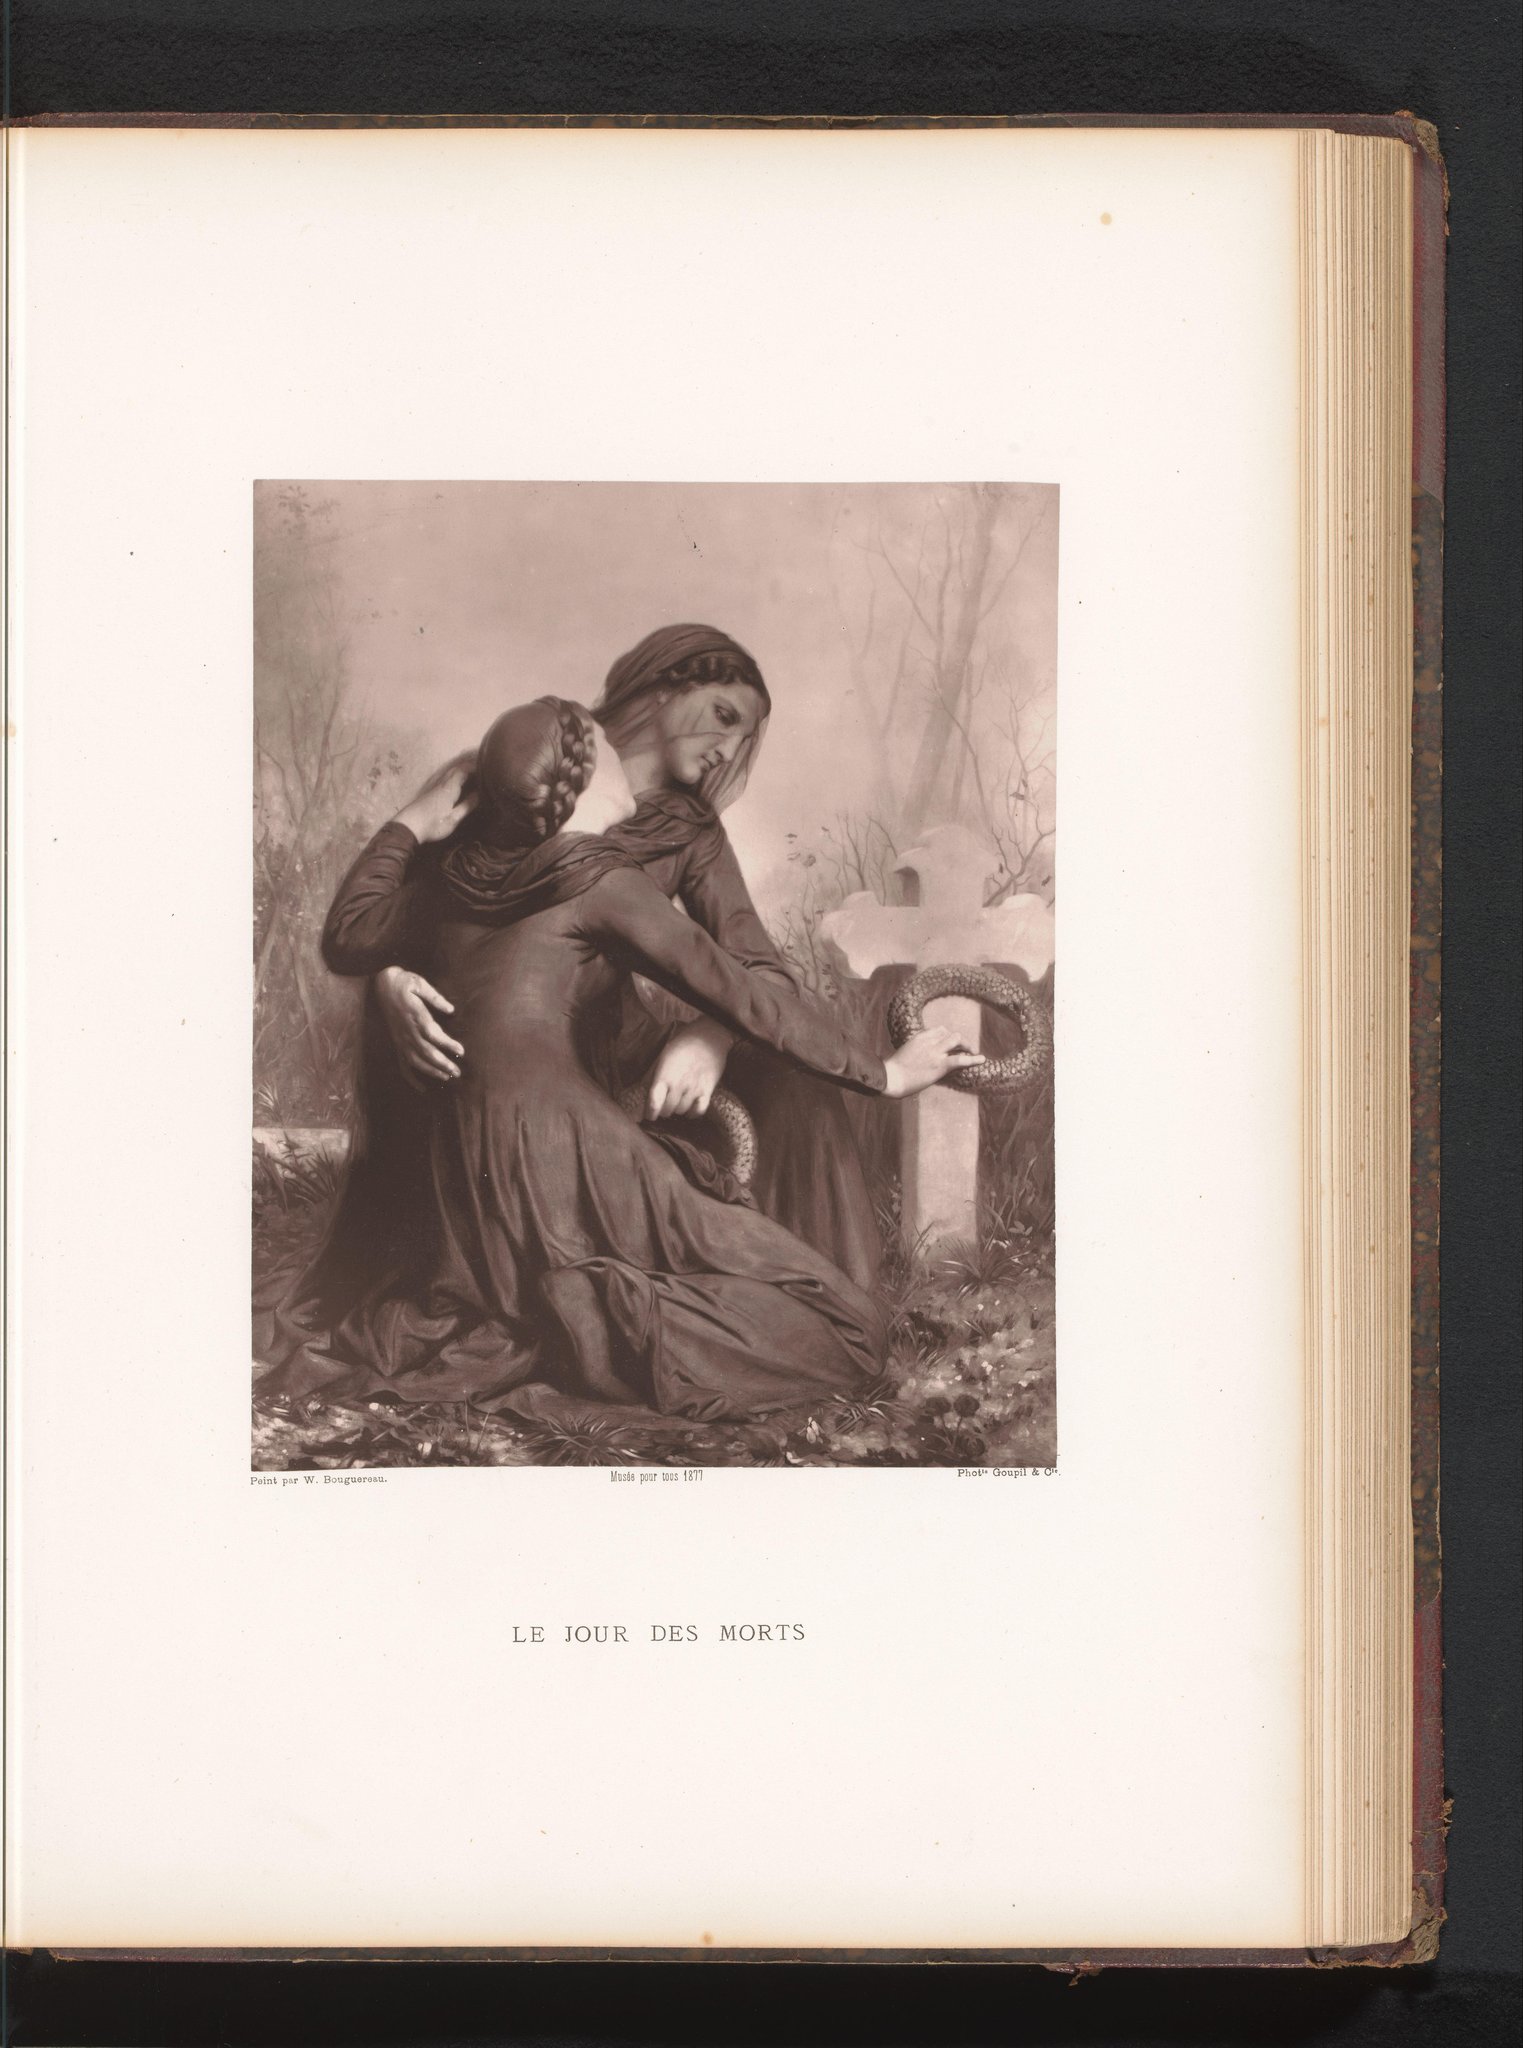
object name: photomechanical print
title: Reproductie van The day of the dead door William-Adolphe Bougeureau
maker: william-adolphe bouguereau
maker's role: draughtsman, painter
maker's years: 1825-1905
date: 1872-1879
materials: paper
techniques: woodburytype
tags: laying flowers or wreath on grave, gravestone, tombstone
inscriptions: inscription: ‘Musée pour tous 1877’